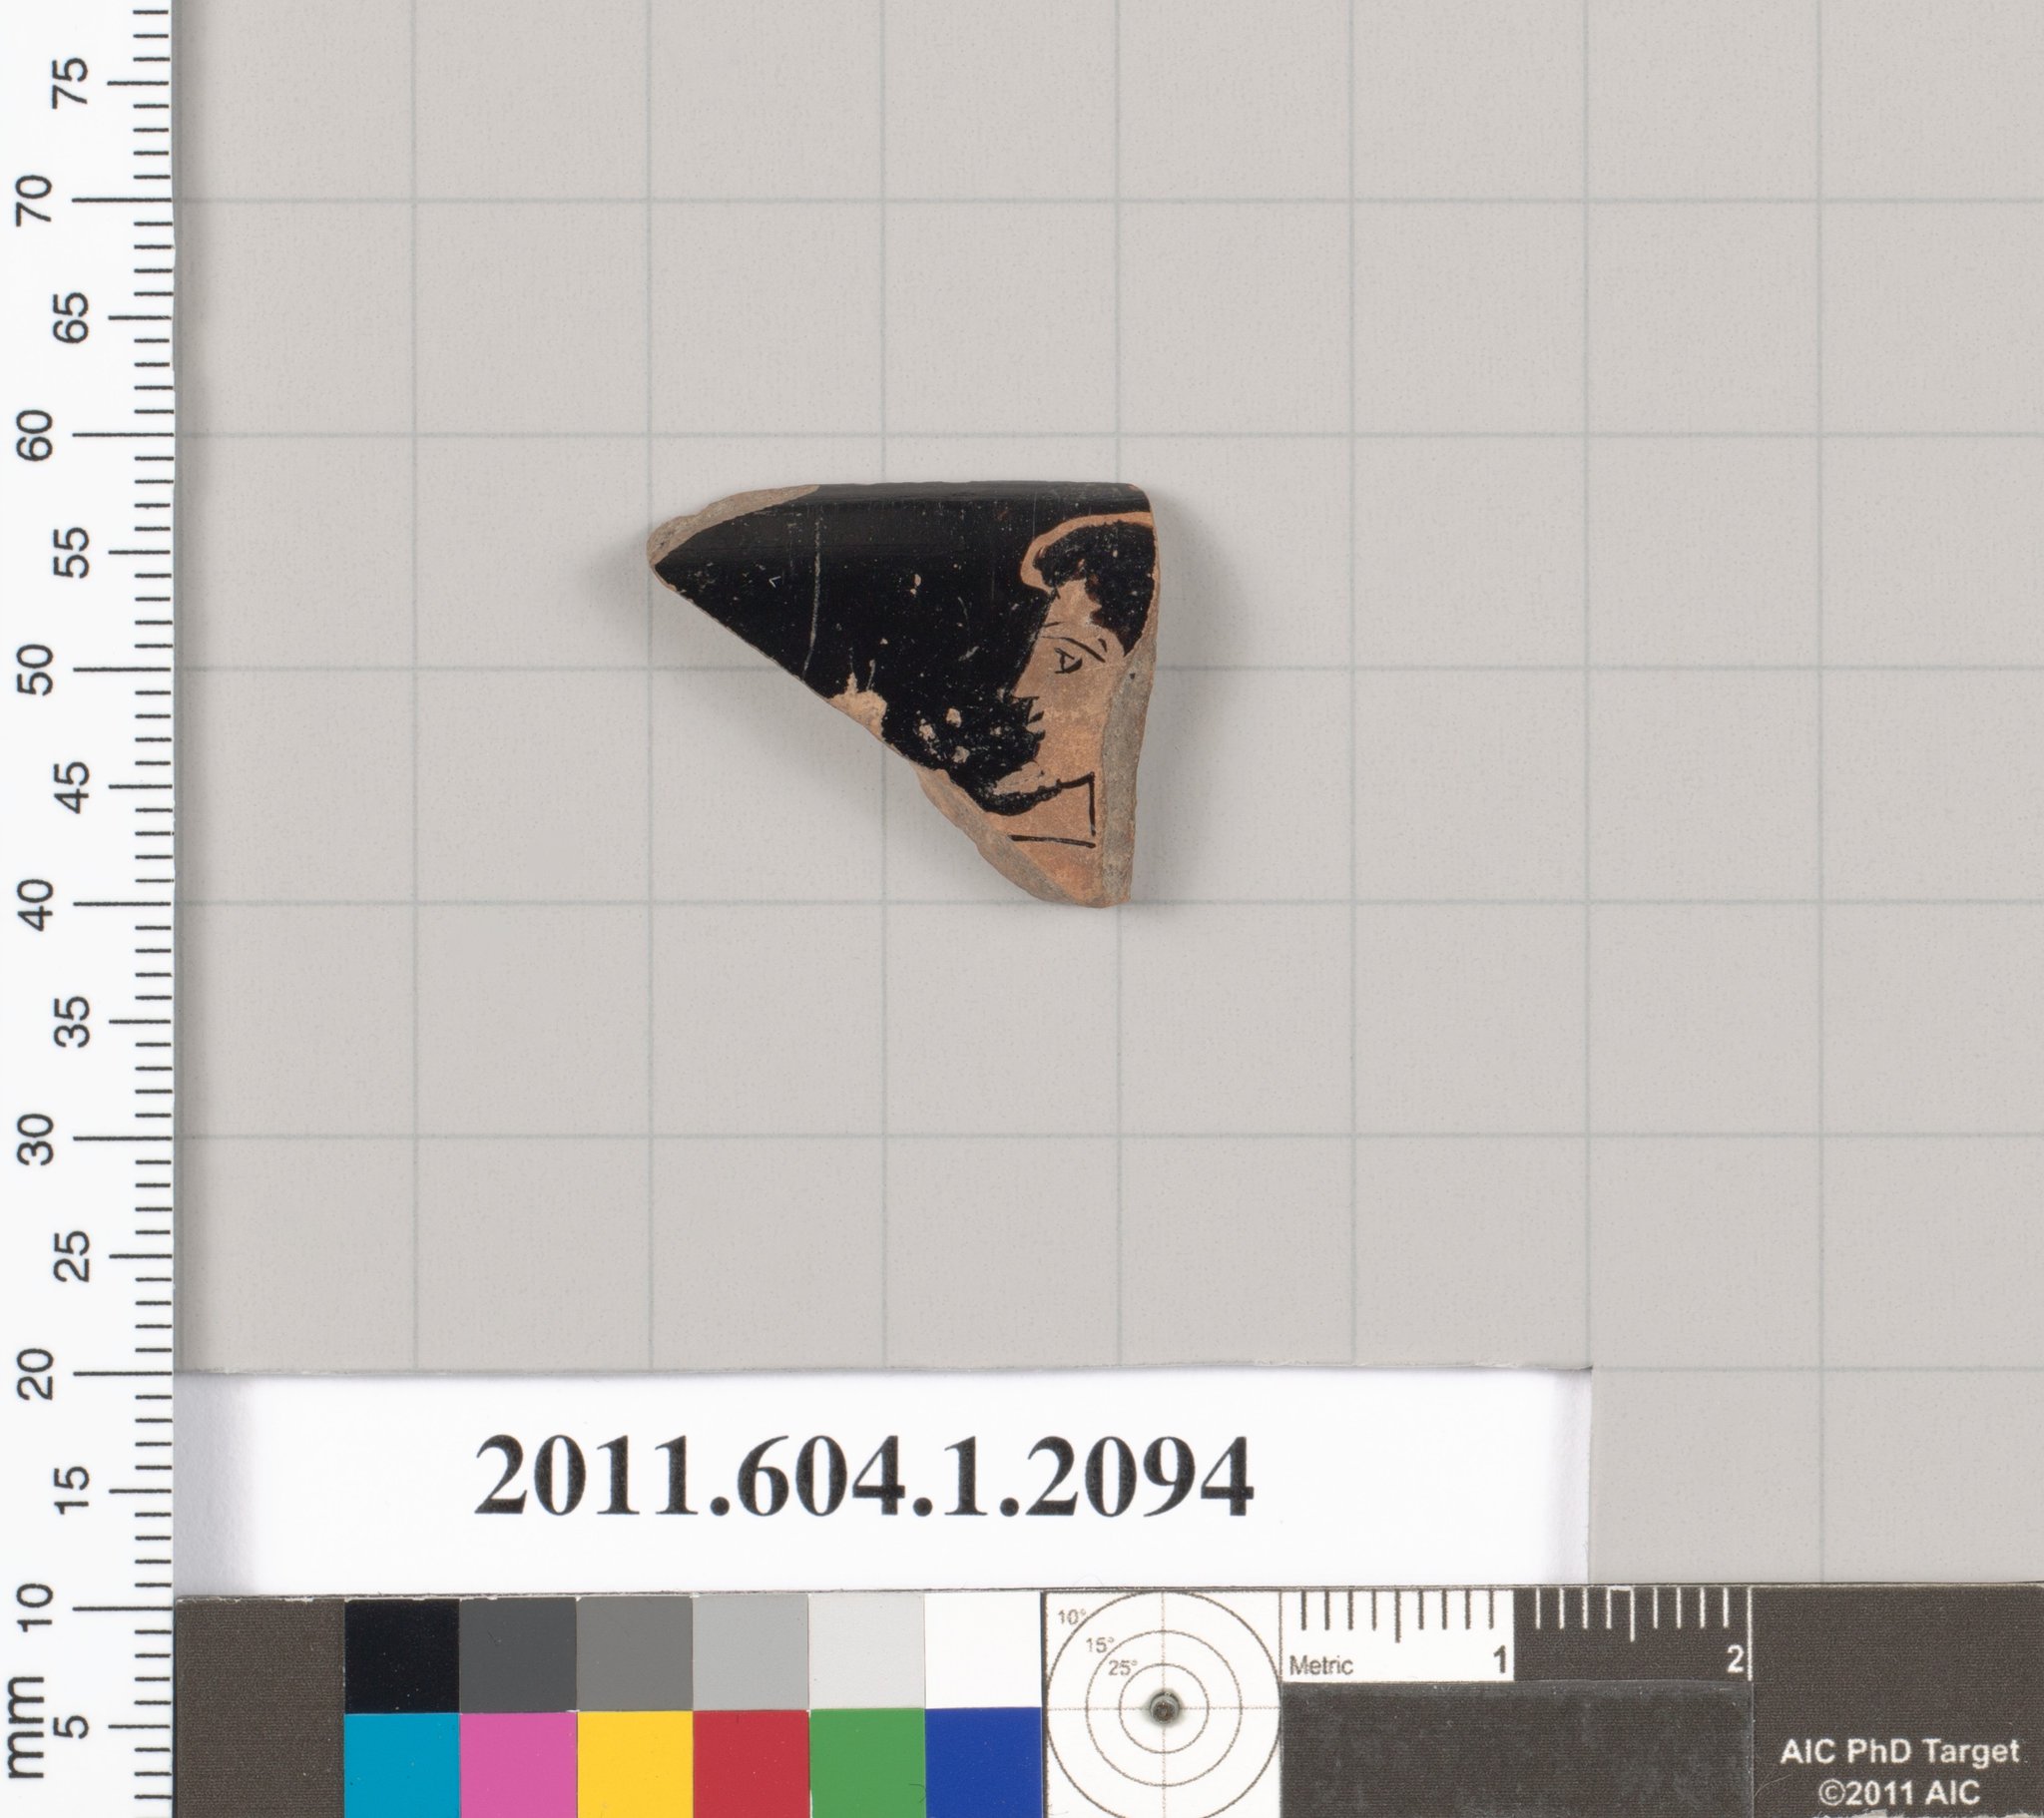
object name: kylix fragment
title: Terracotta rim fragment of a kylix (drinking cup)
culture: greek, attic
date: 475-451 BCE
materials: terracotta